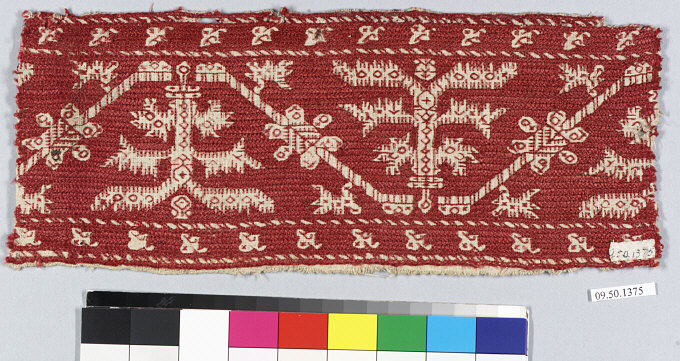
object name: band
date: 1501-1600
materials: linen, silk